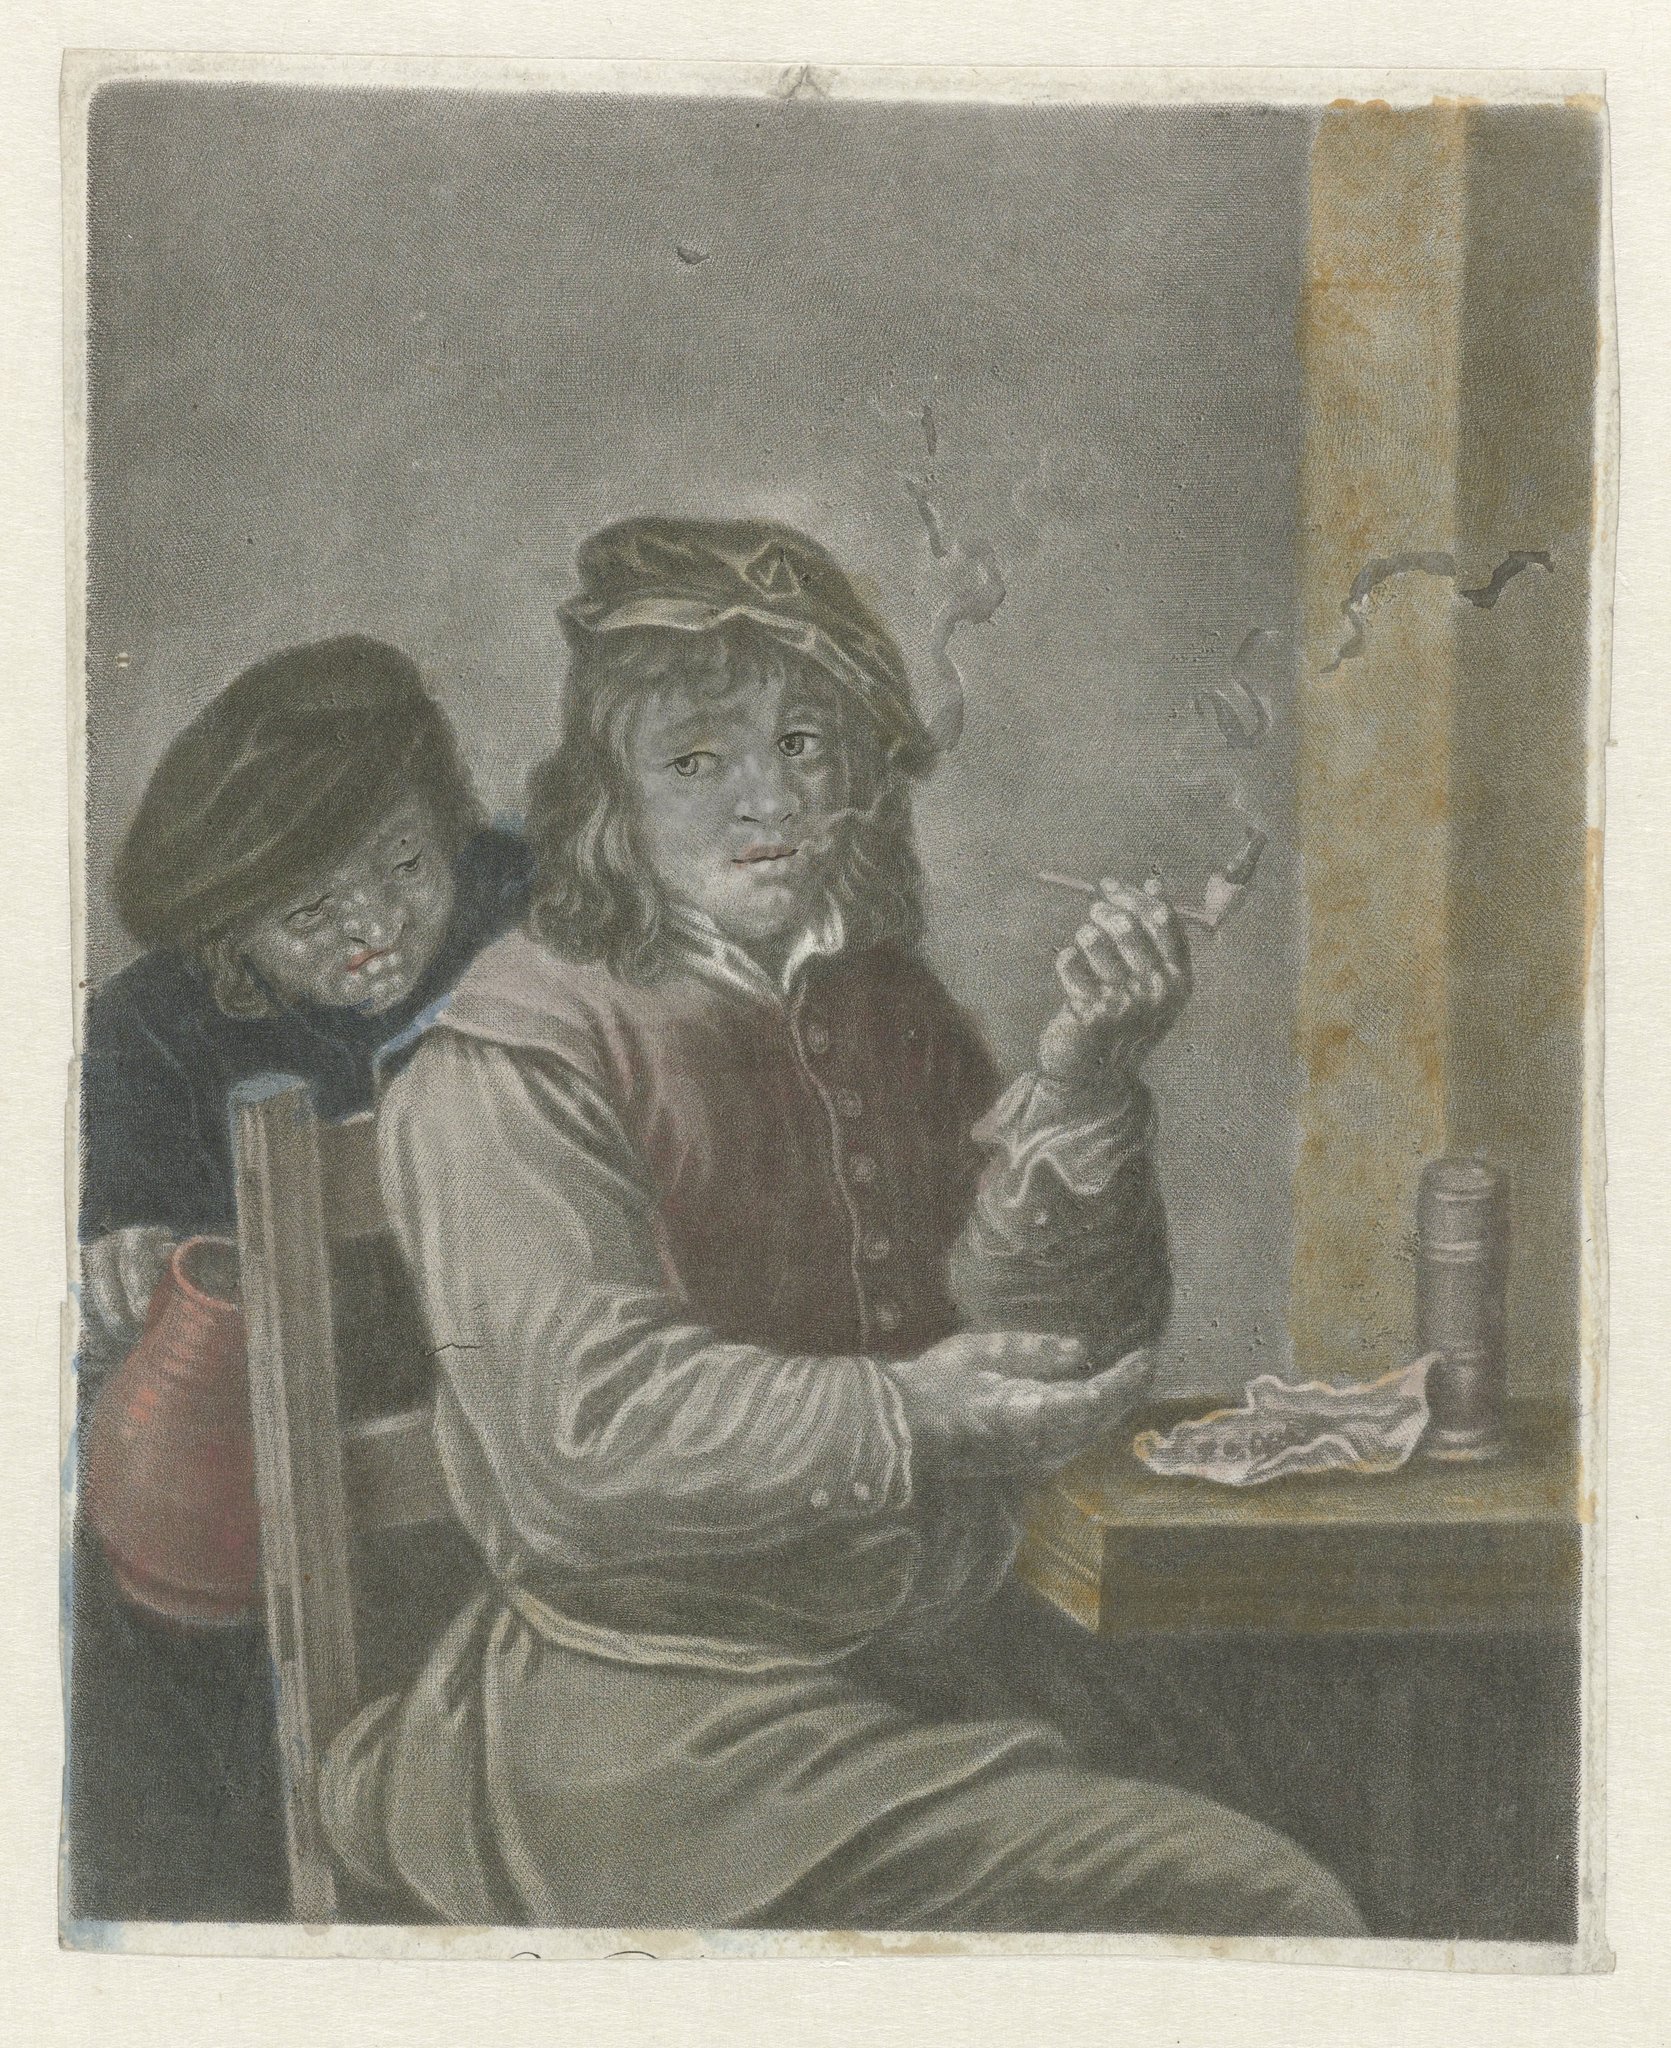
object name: print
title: Pijproker, zittend aan een tafel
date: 1650-1700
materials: paper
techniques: hand coloring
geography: netherlands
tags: pipe ~ tobacco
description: Na de overname van de firma Niemeyer door British American Tabacco Group besloot deze de collectie van het Niemeyer Tabaksmuseum af te stoten. De beheerder van de collectie, het Noordelijk Scheepvaartmuseum, organiseerde in januari 2011 open dagen voor musea waar deze hun voorkeuren voor collectieonderdelen kenbaar konden maken. De objecten zijn getaxeerd door medewerkers van Christie's en vervolgens ter overname aangeboden aan de belangstellende musea. Het Rijksprentenkabinet koos 46 prenten uit de collectie tegen door de medewerkers van Christie's vastgestelde waarde. [H. Leeflang, 2011-06-09]